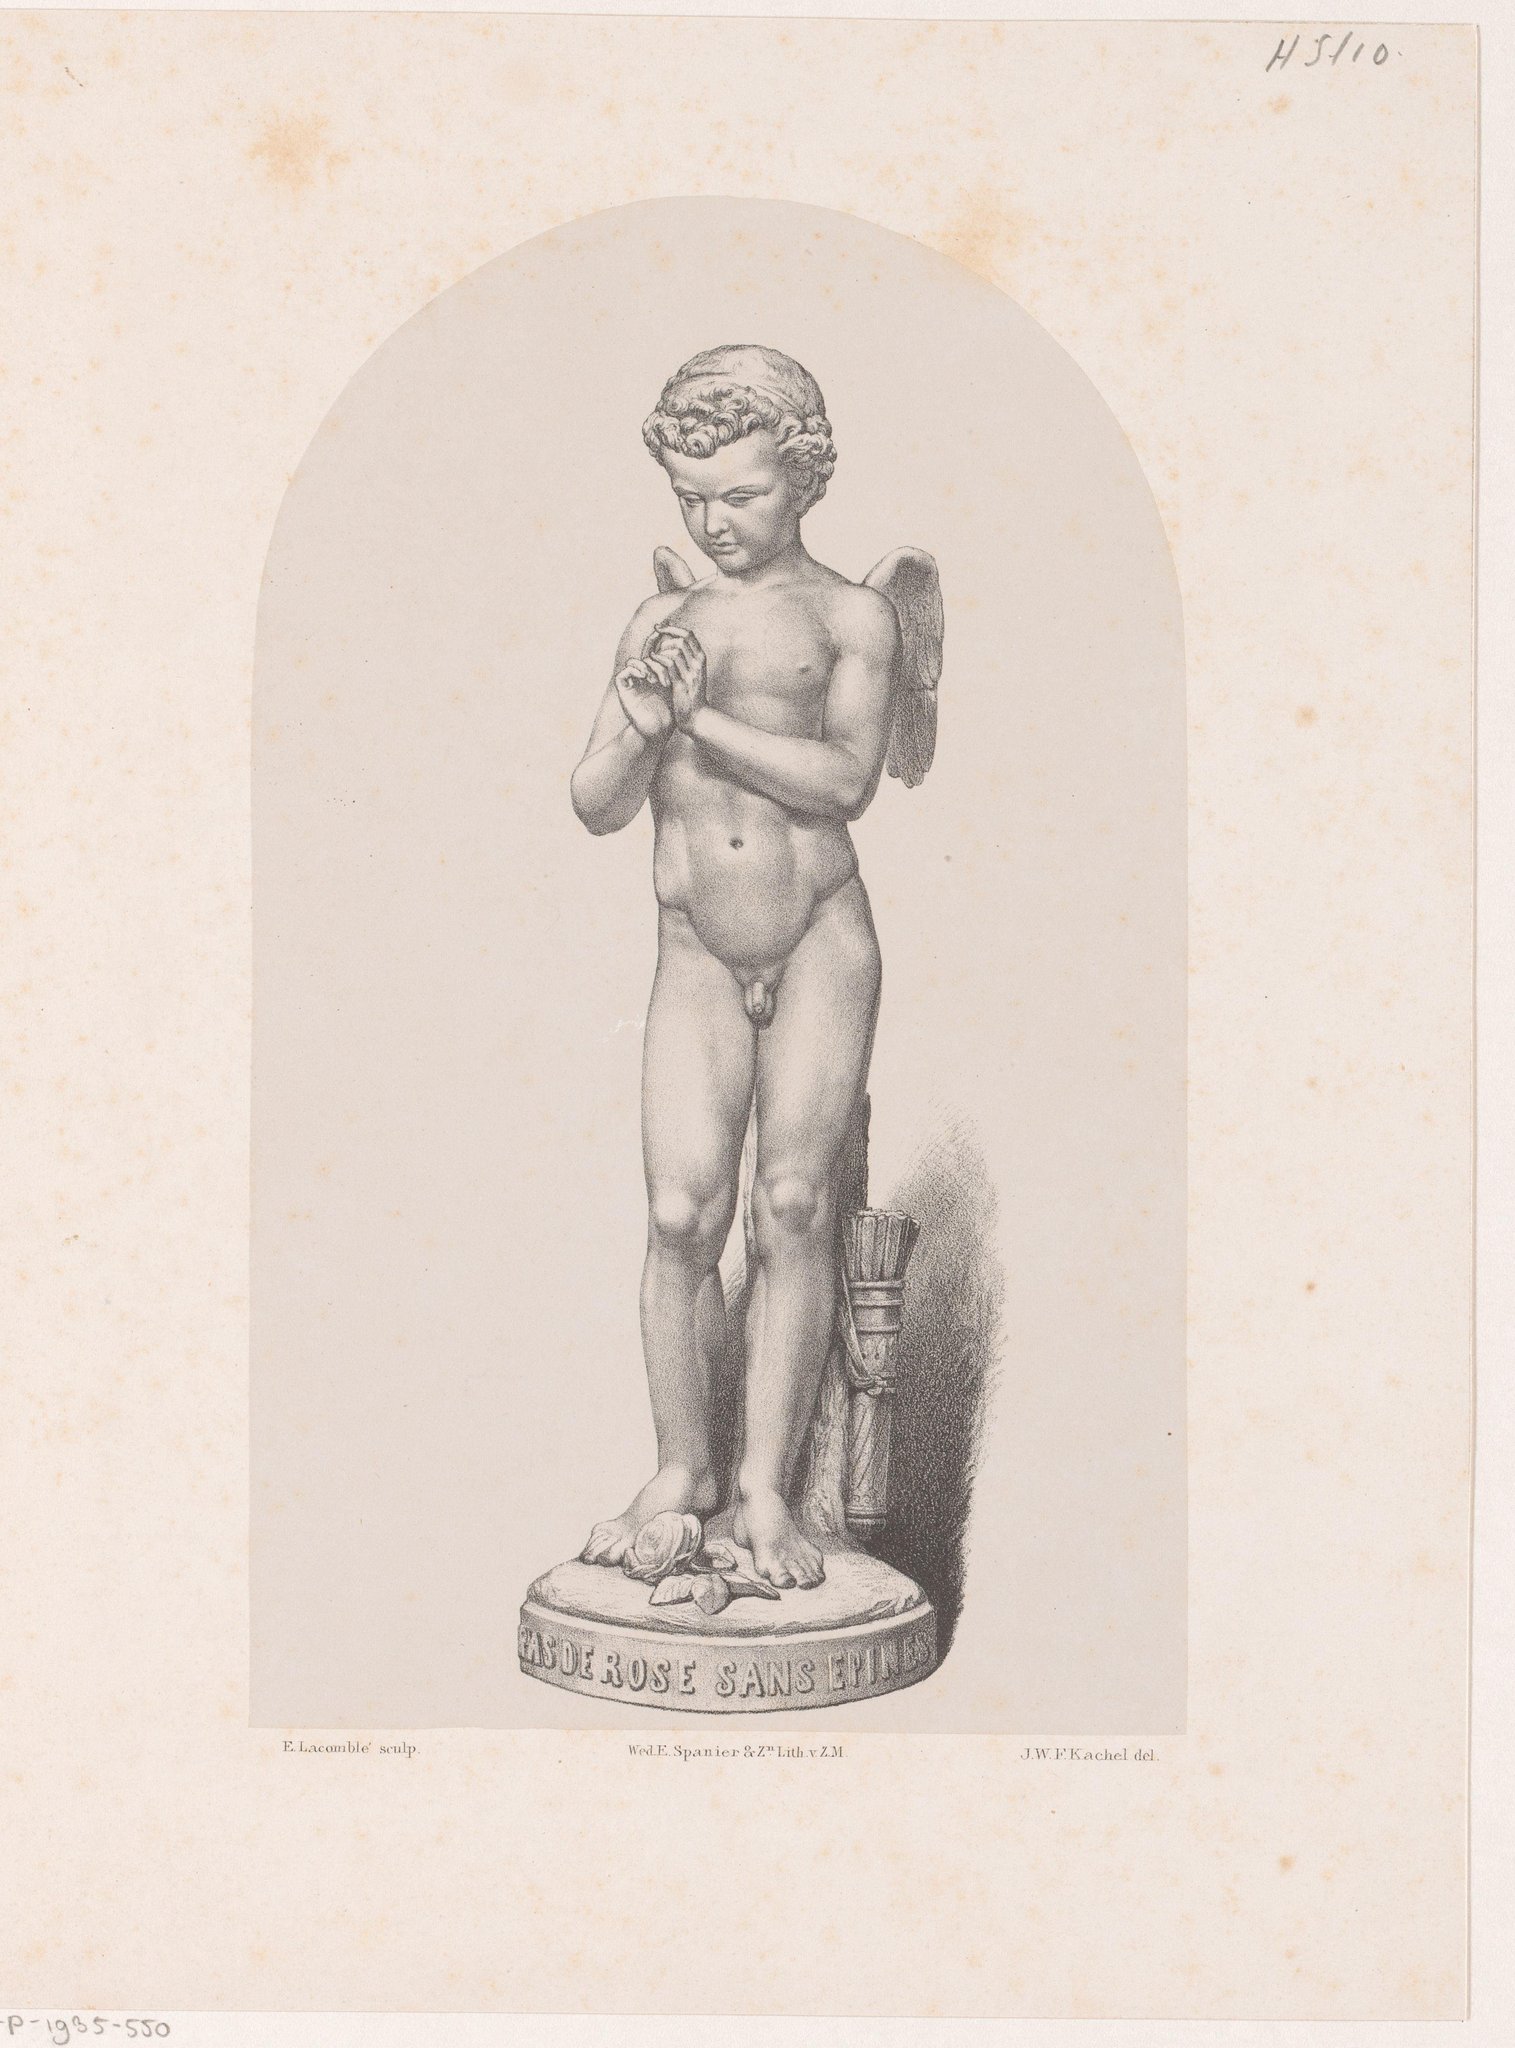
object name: print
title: Pas de rose sans epines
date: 1863-1883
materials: paper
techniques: lithograph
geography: the hague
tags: (story of) cupid, amor (eros), flowers: rose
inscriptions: collector's mark: Lugt 2228, collector's mark: Lugt 2760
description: Amor kijkt naar zijn vinger, op de grond ligt een roos. De inscriptie op de sculptuur verwijst naar de uitspraak: er is geen roos zonder doorns, net zo min als er liefde bestaat zonder pijn.